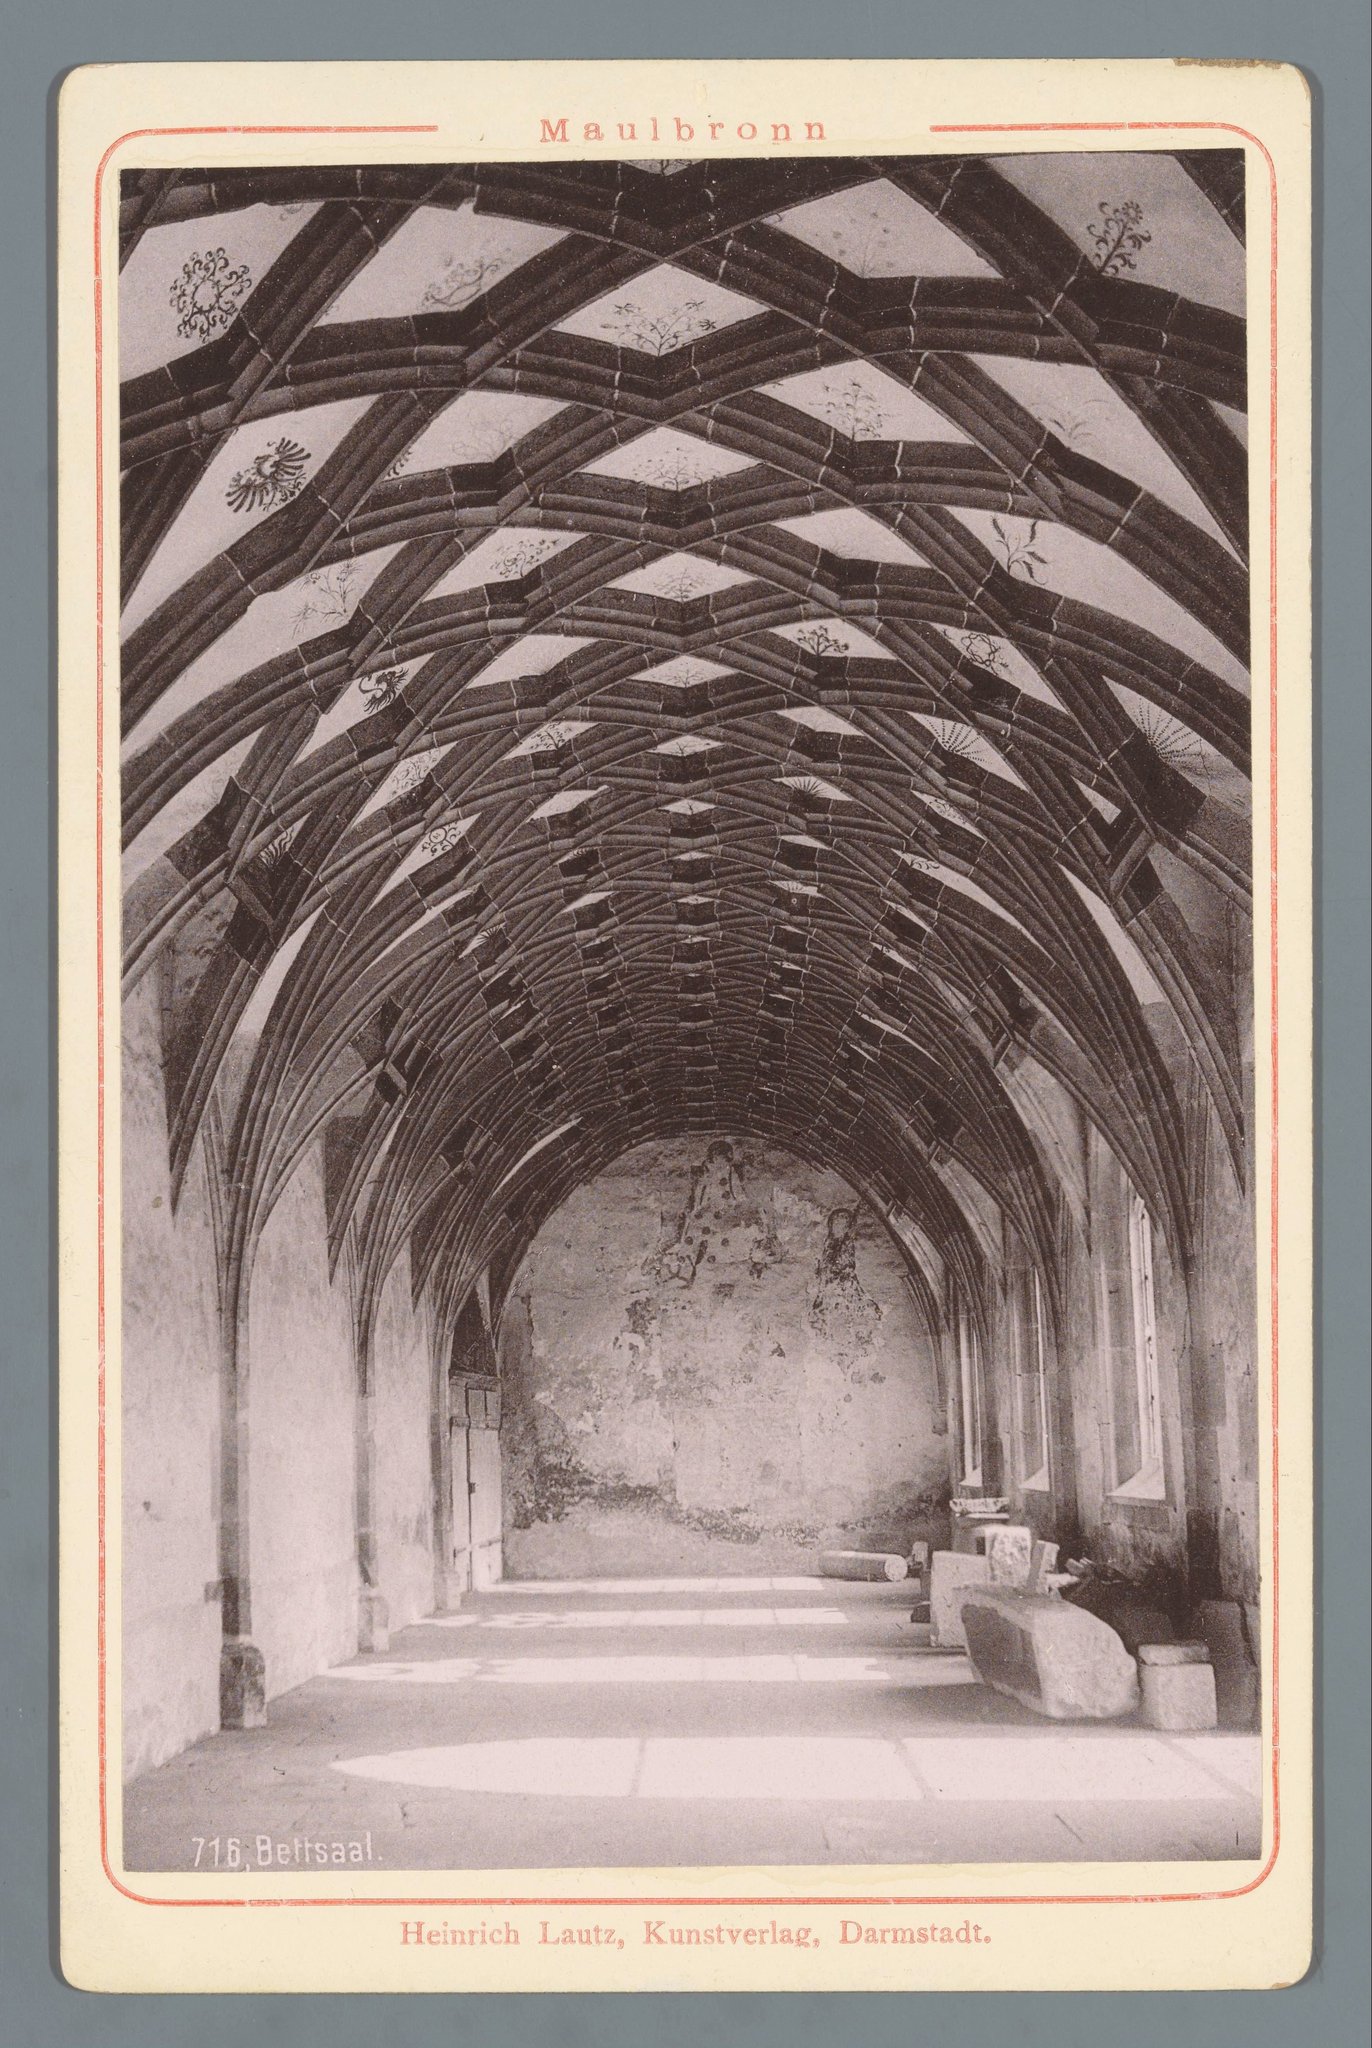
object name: photomechanical print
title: Slaapzaal in de Abdij van Maulbronn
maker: Anonymous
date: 1895-1900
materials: cardboard, paper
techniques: photograph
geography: maulbronn abbey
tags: abbey, monastery, convent ~ roman catholic church, dormitory ~ monastery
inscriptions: inscription: ‘17 Juli 1894.’, number: ‘716’